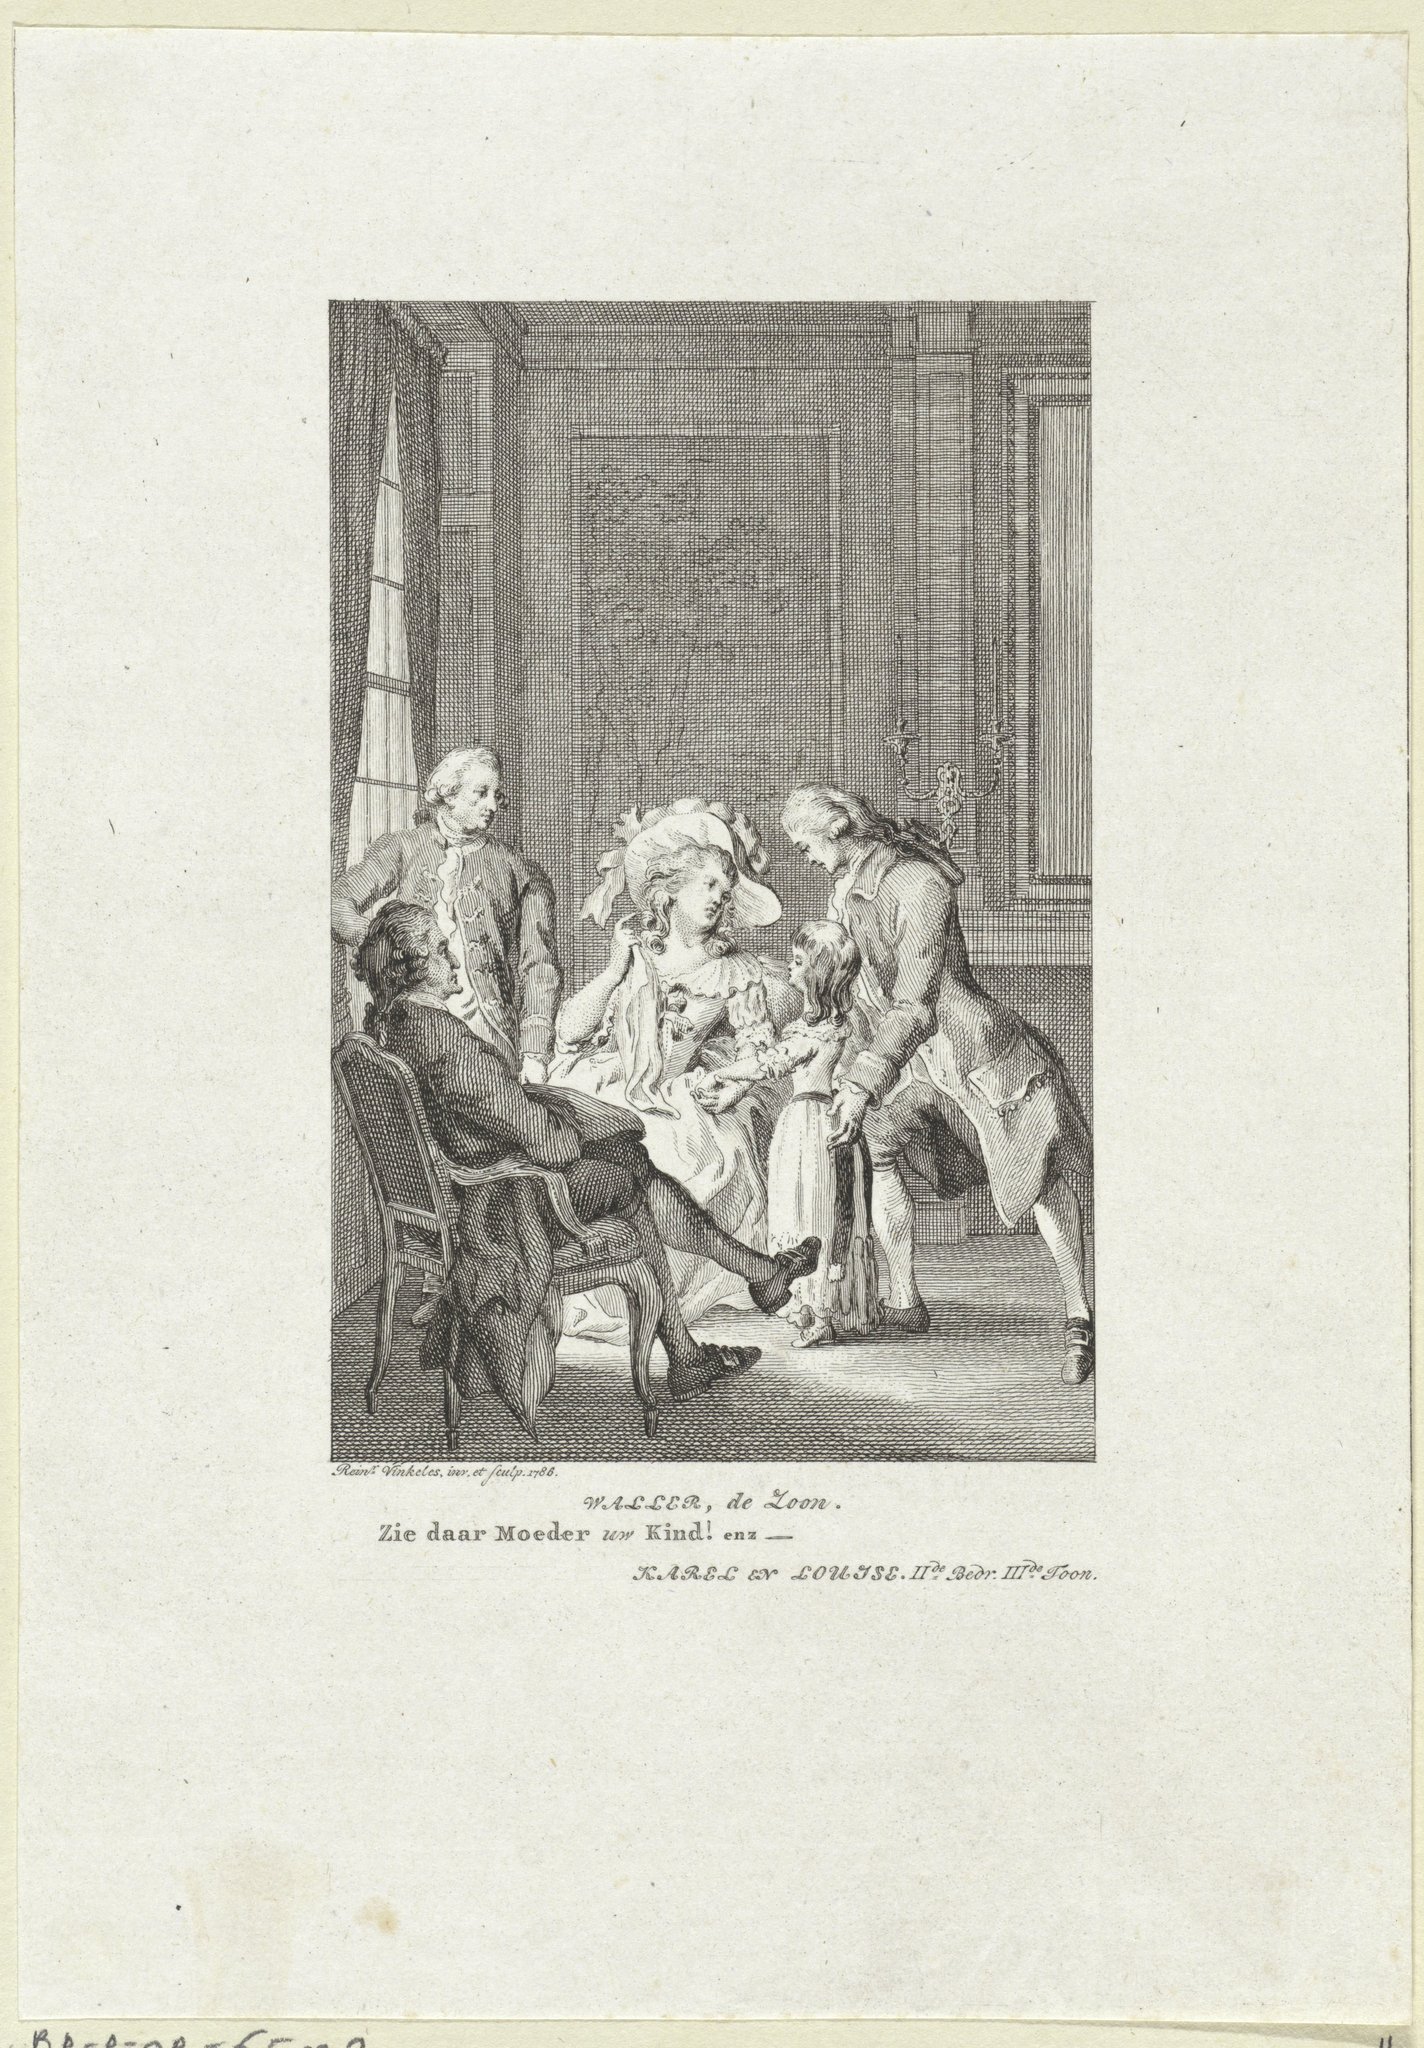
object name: print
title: Jong kind wordt bij de moeder gebracht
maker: reinier vinkeles (i)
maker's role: draughtsman, print maker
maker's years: 1741-1816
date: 1786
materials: paper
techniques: engraving, etching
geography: amsterdam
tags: head-gear: hat, mother and child(ren), woman and child(ren) (family group)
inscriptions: collector's mark: Lugt 240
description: Deze prent is mogelijk ook gebruikt als illustratie voor: Karel en Louise, of de dubbele echtverbindtenis. Amsterdam: Erven Pieter Meĳer en Gerrit Warnars, 1787.